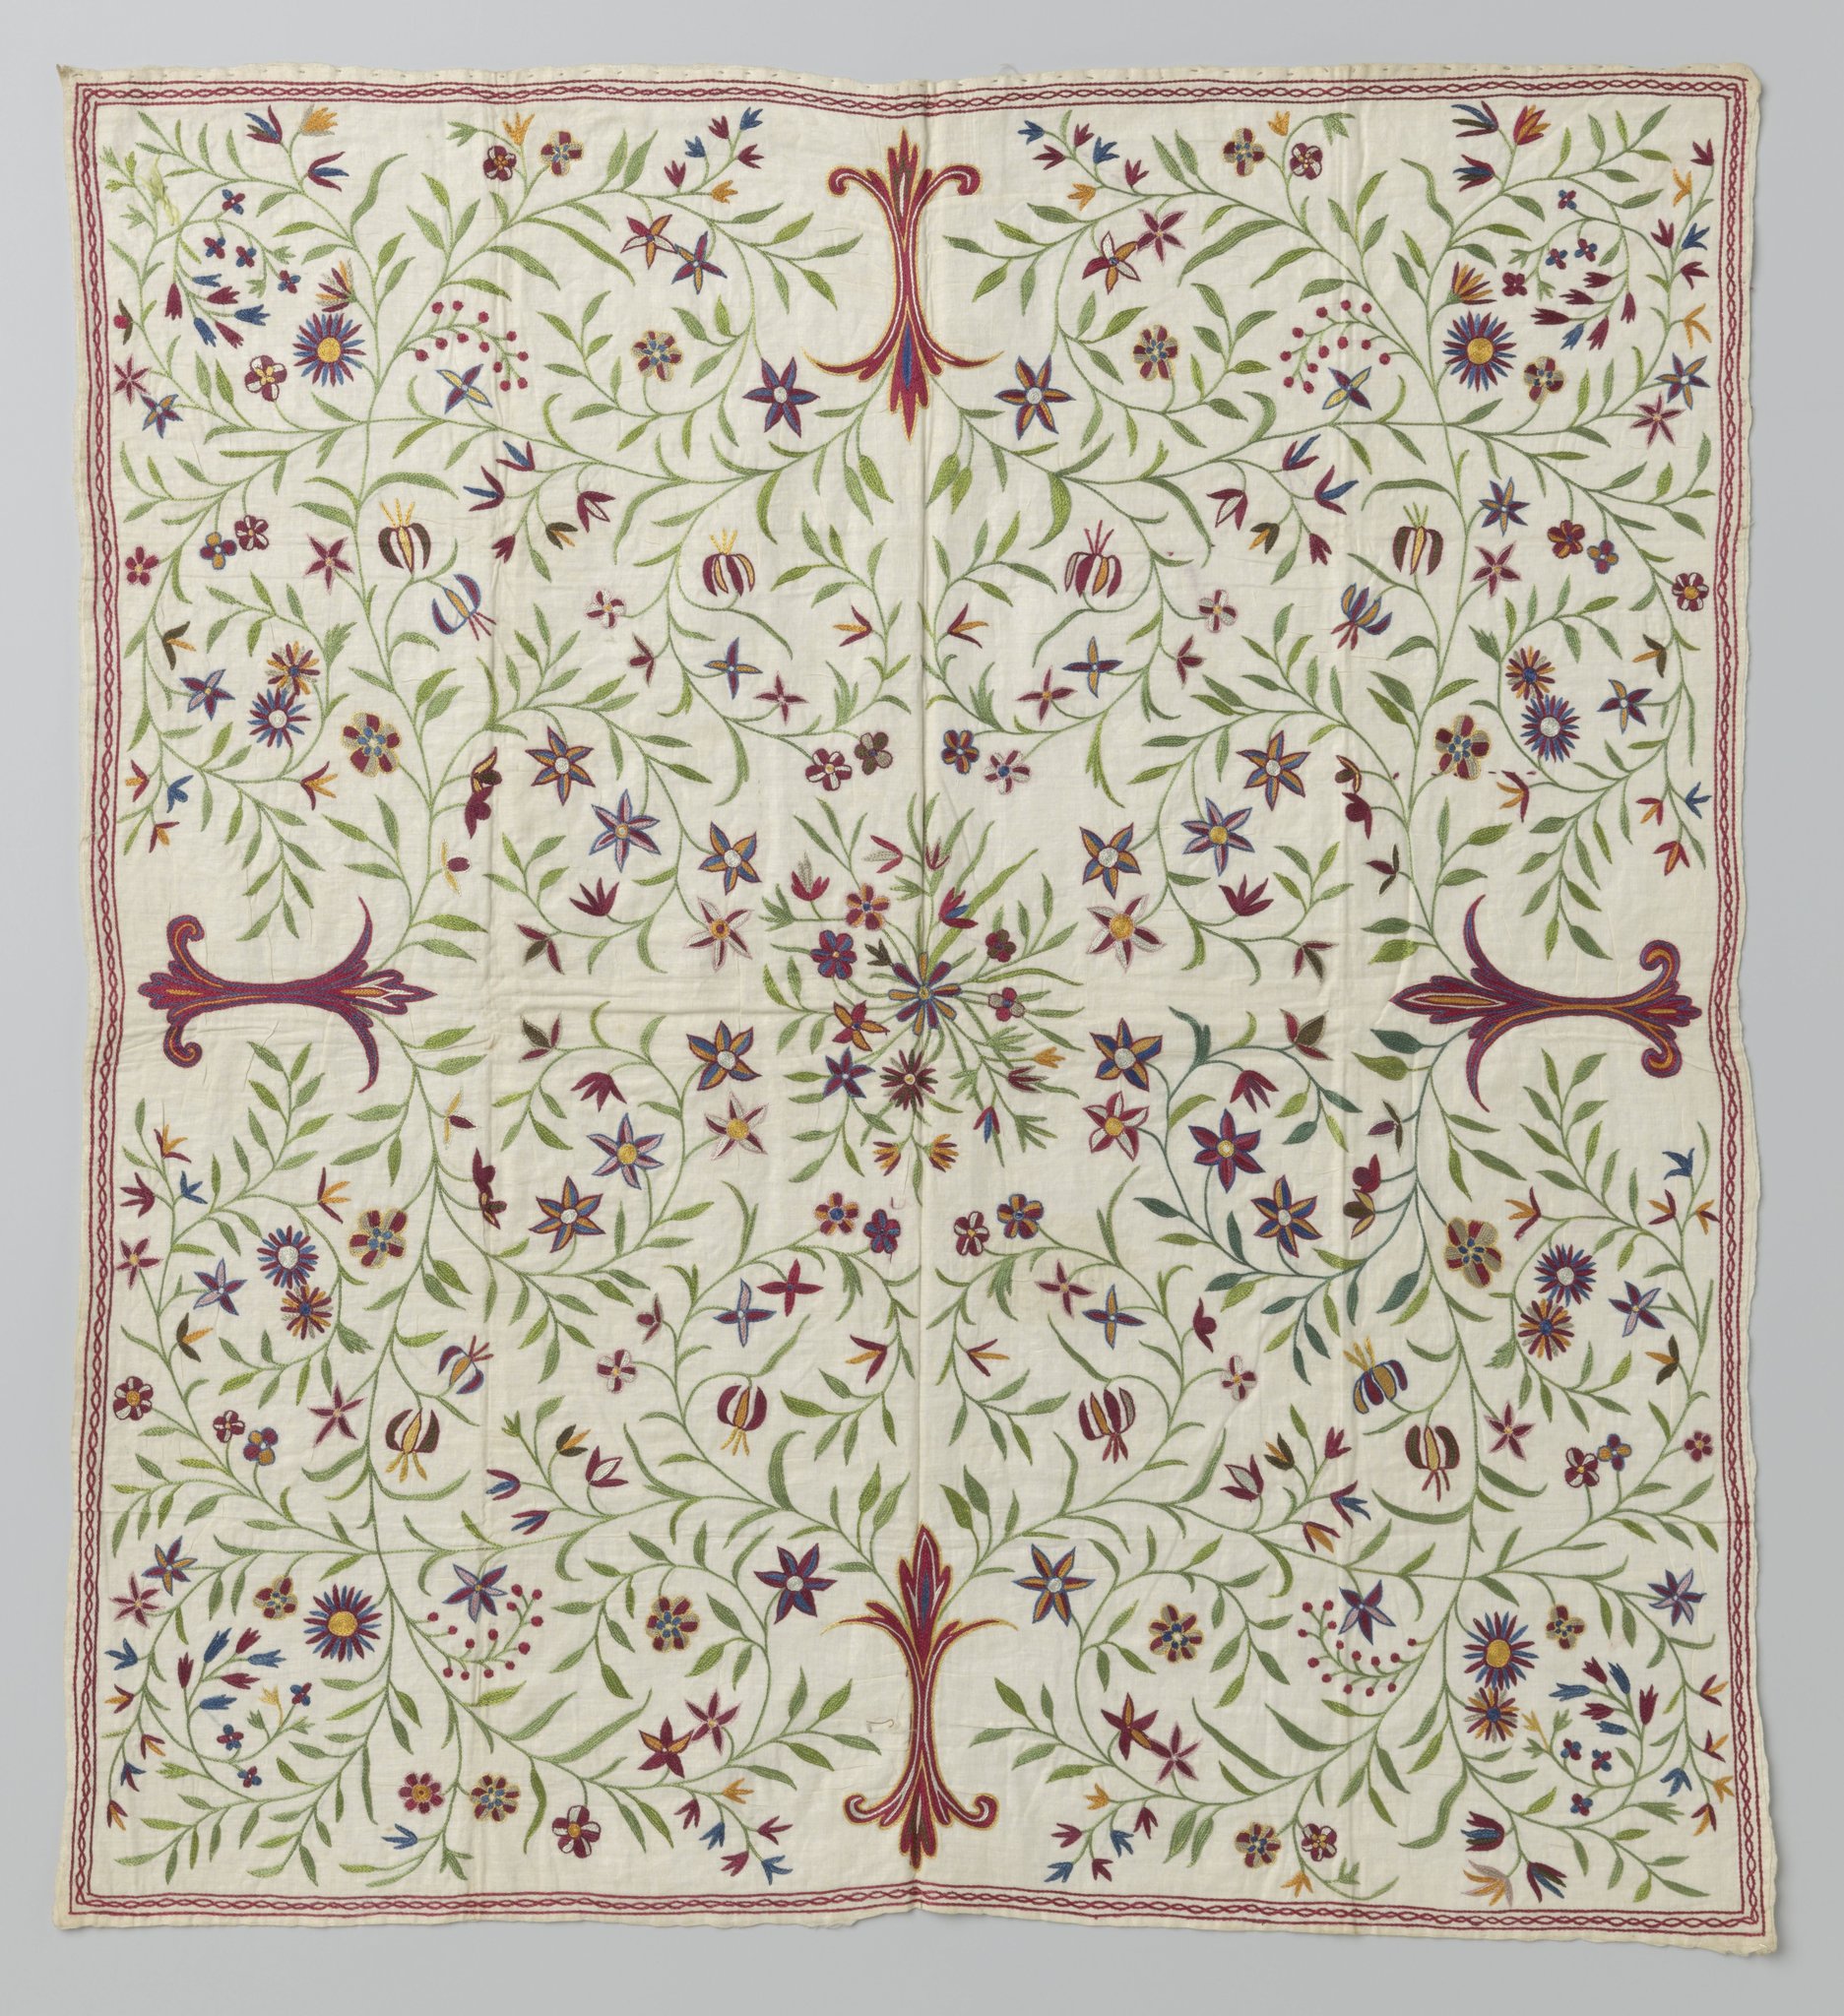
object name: textile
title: Kleed van oosterse textiel met veelkleurig borduurwerk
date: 1800-1899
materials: cotton, silk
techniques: embroidered, weave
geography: east indies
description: Kleed van veelkleurig getamboereerde katoen, versierd met bloemenranken en ornament, gevoerd met katoen.